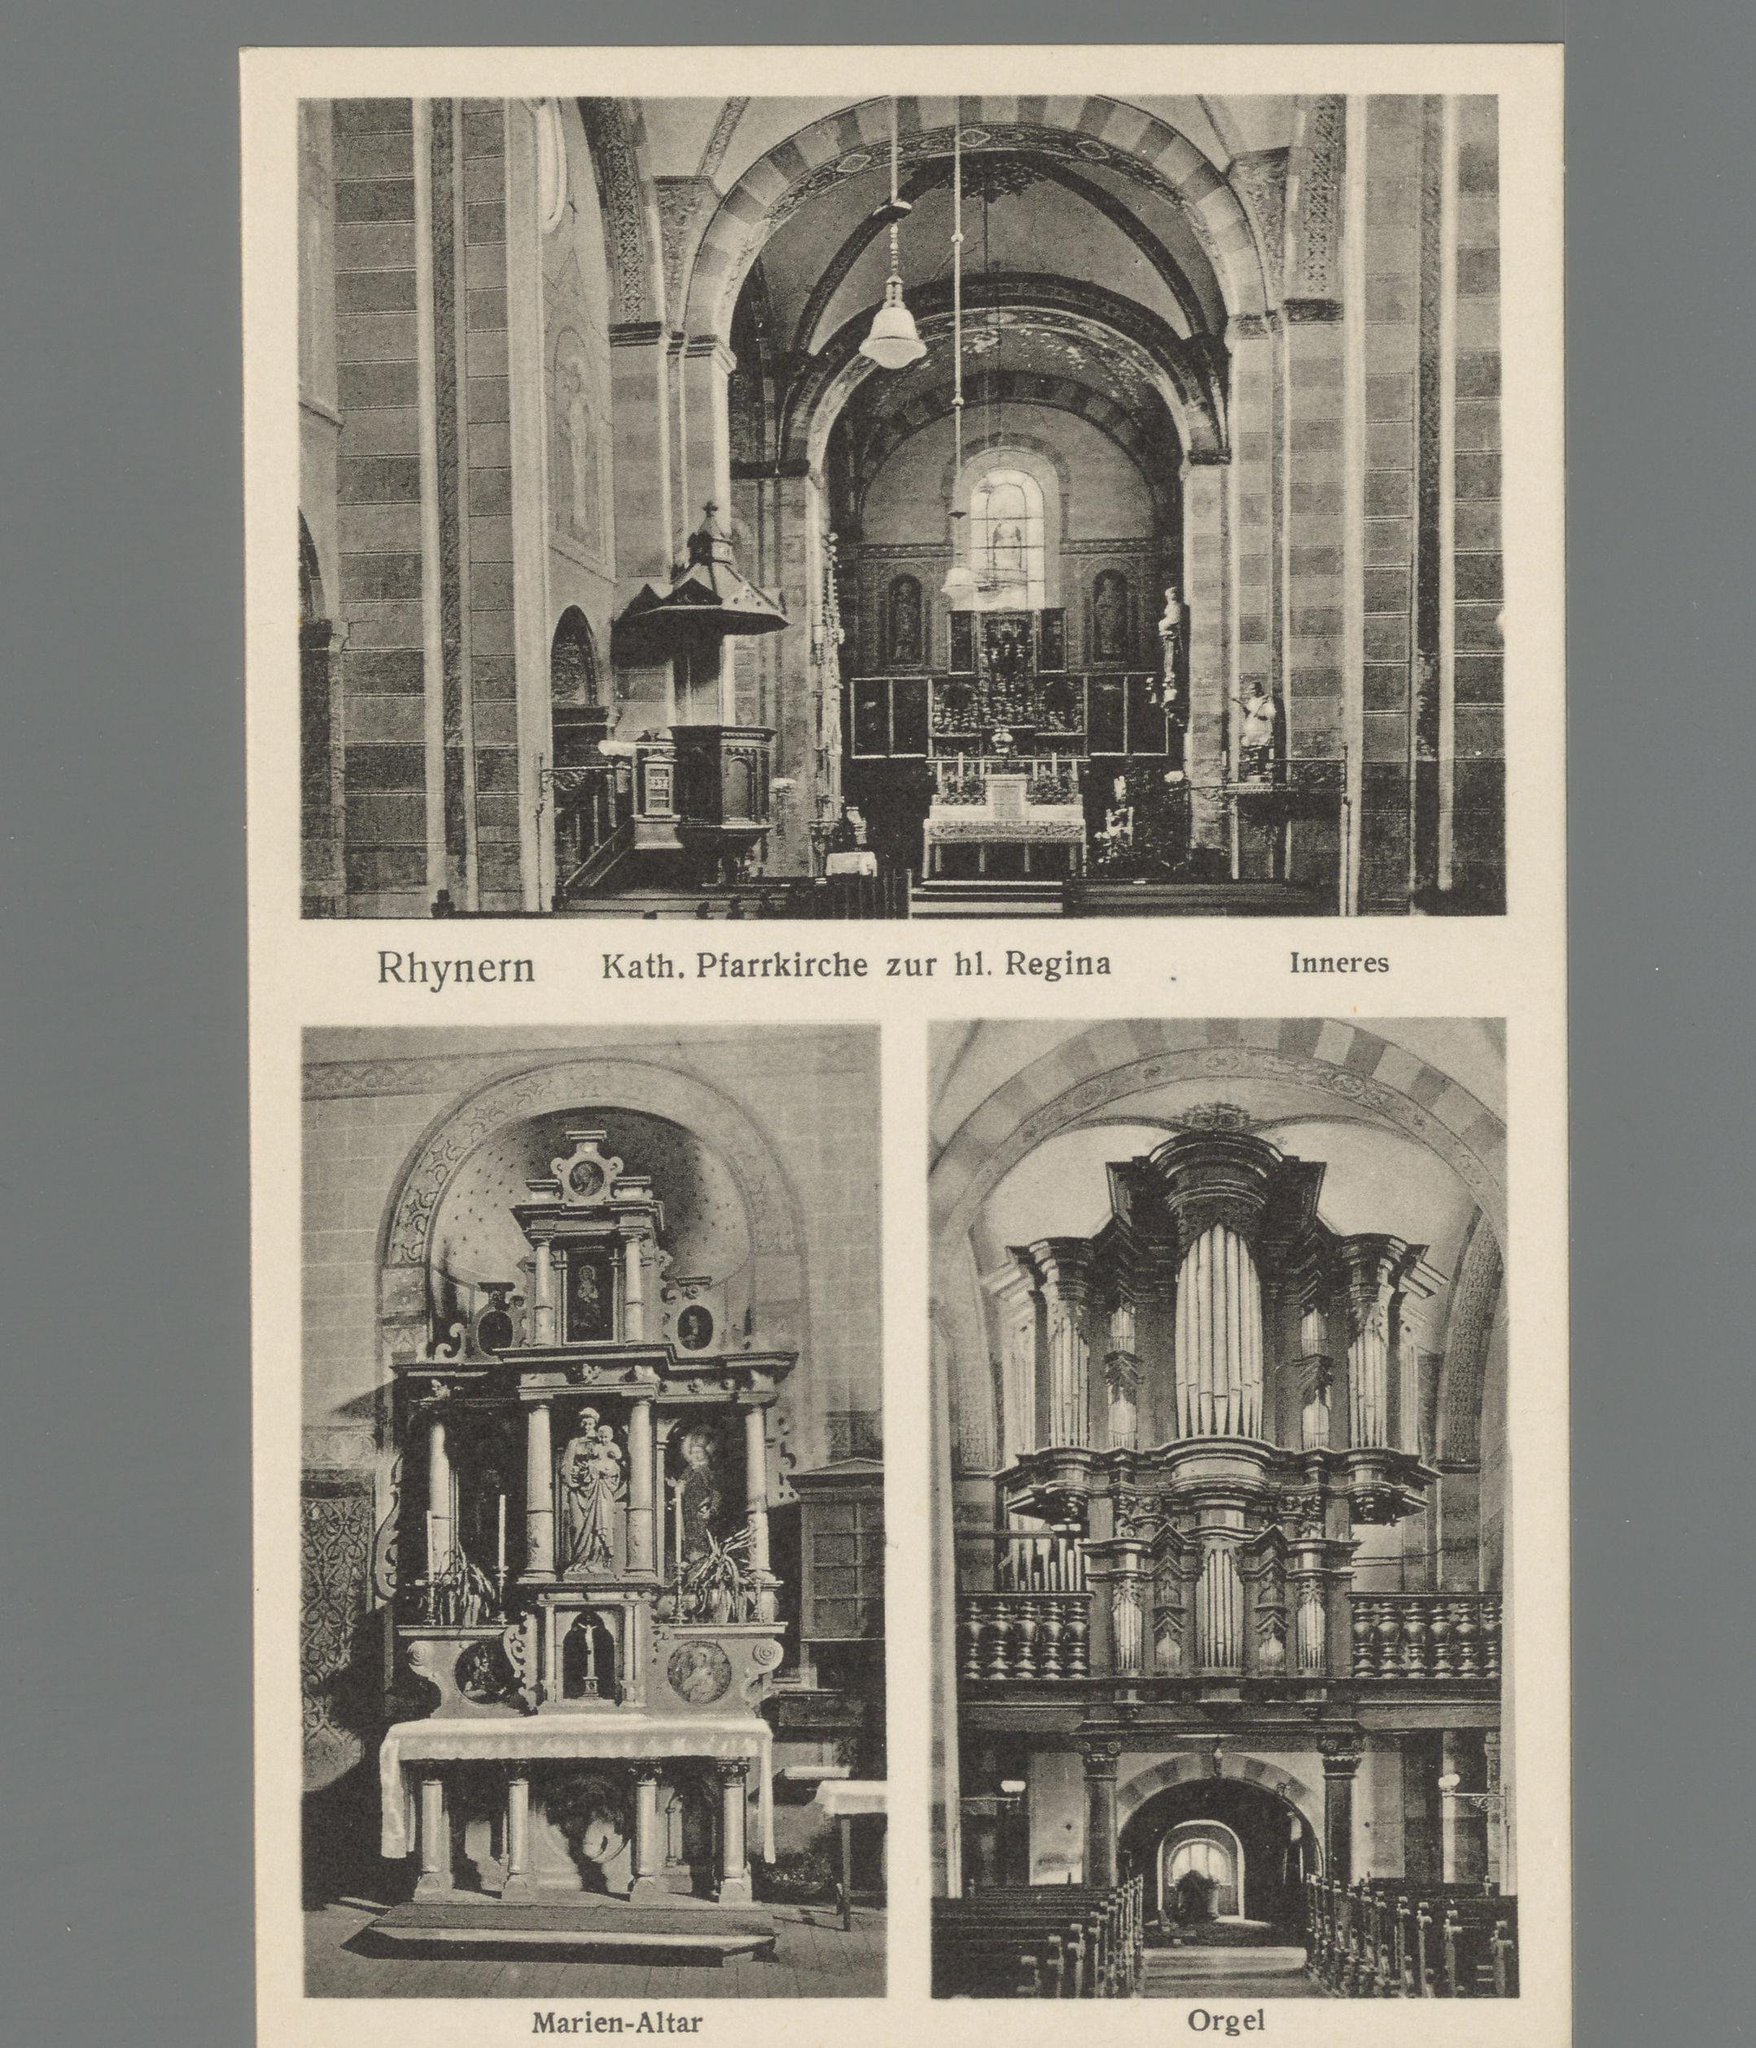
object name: ansichtkaart, prentbriefkaart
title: Rhynern. Kath. Pfarrkirche zur hl. Regina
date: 1905-1930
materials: cardboard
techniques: photograph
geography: rhynern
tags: church organ, interior of church, altar with altar-piece